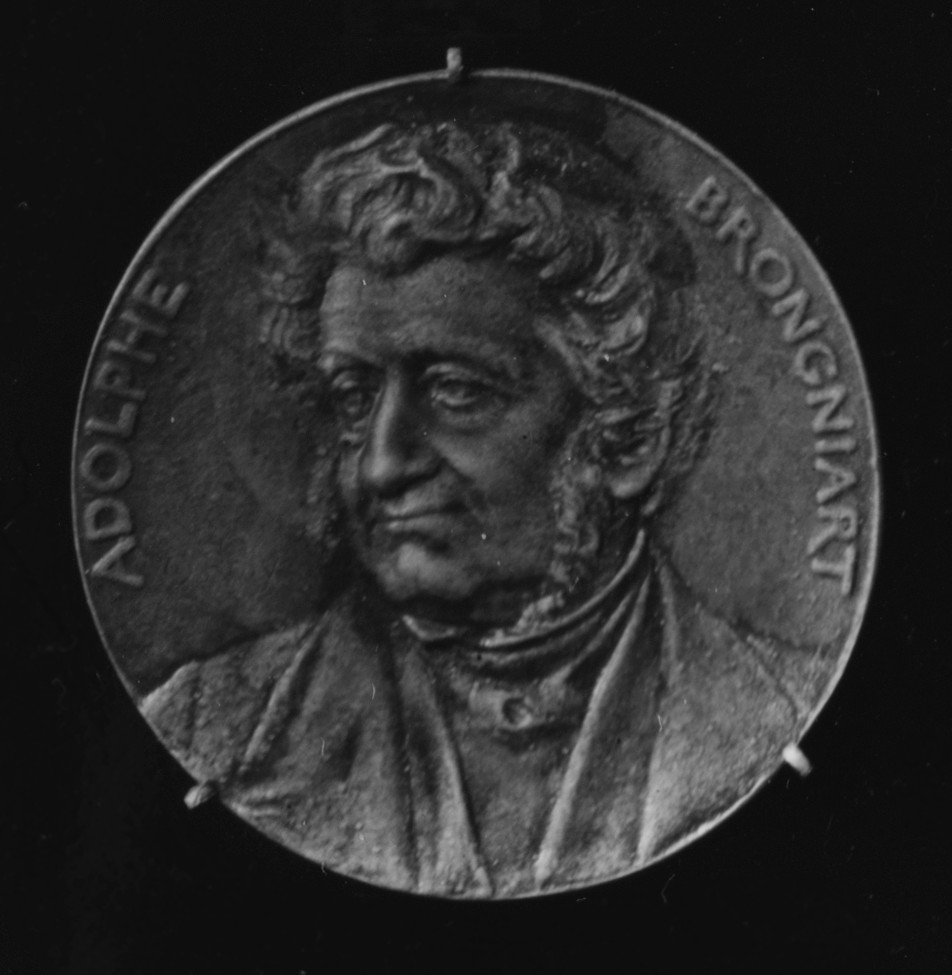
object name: medal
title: Portrait of Adolphe Brongniart, of the Academy of Sciences, 1880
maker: louis-oscar roty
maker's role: artist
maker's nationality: french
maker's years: 1846-1911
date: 1880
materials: bronze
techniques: casting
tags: men,portraits